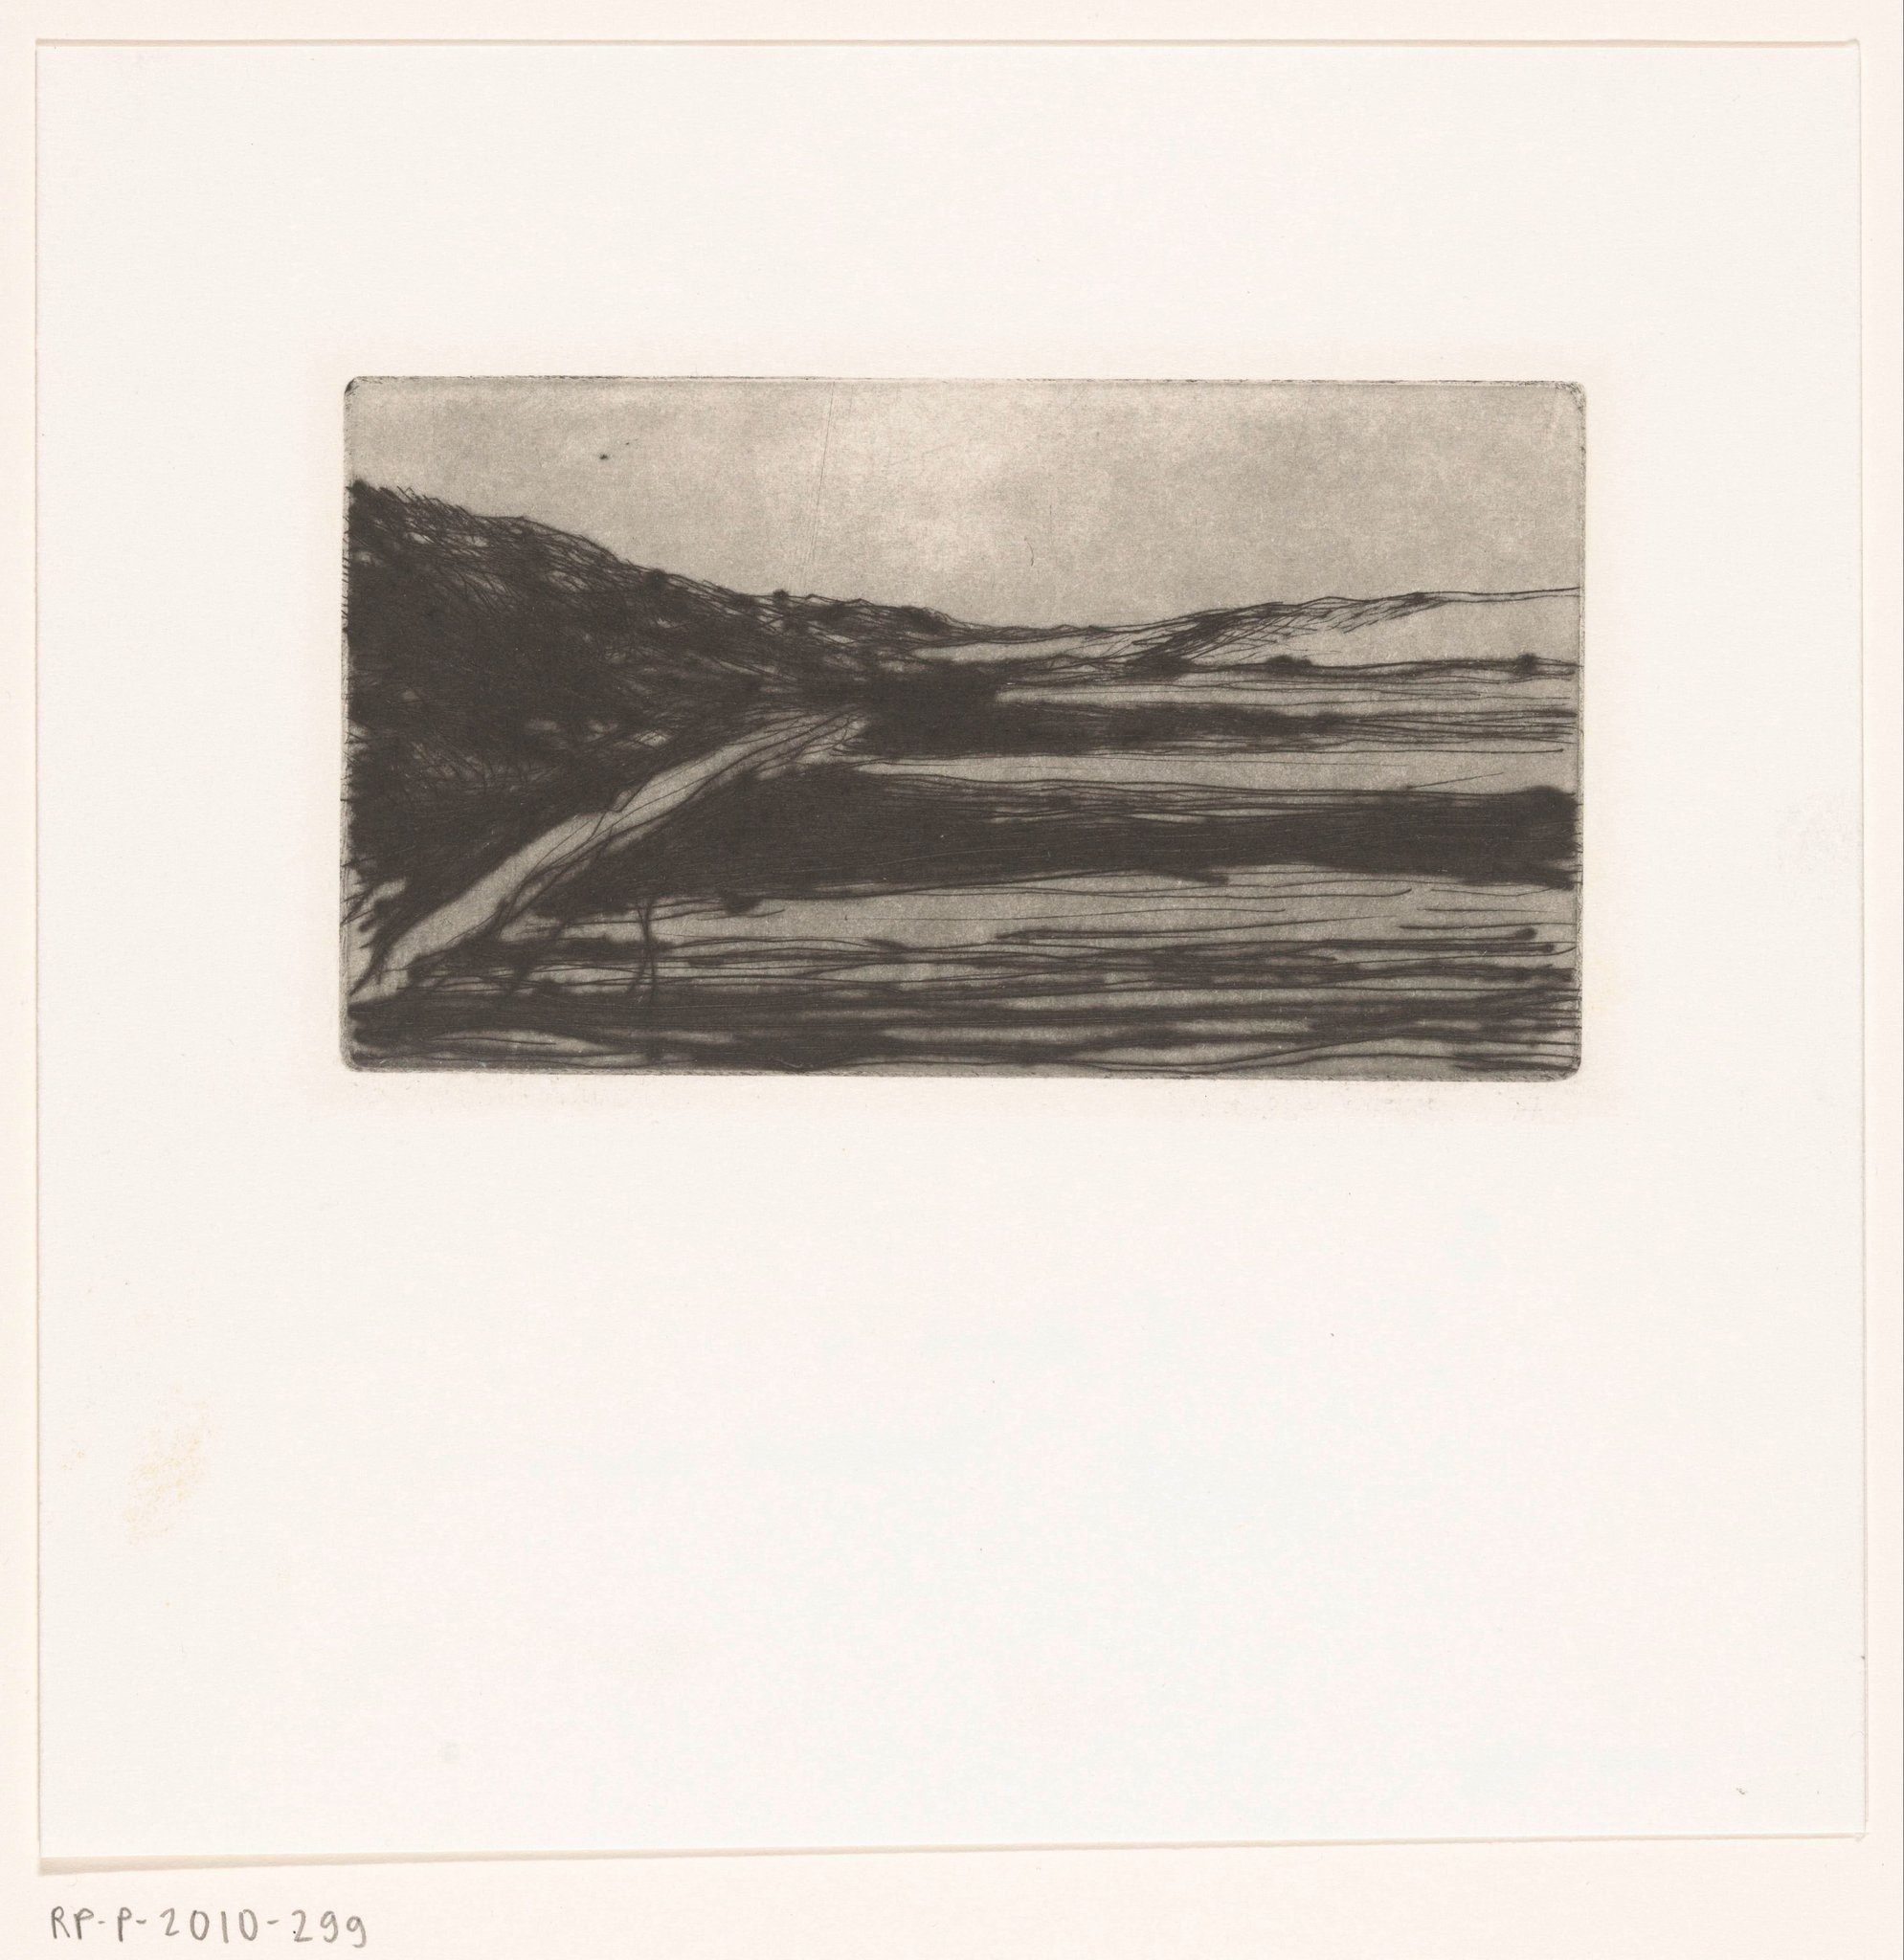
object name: print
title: 't Zwin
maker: ronald noorman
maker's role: draughtsman, print maker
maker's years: 1951-2018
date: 1908-1977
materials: paper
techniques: drypoint, intaglio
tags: dune coast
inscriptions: collector's mark: Lugt 2228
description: Natuurgebied Het Zwin, gezien vanuit de richting van Cadzand in Zeeuws-Vlaanderen. Links en op de achtergrond duinen.